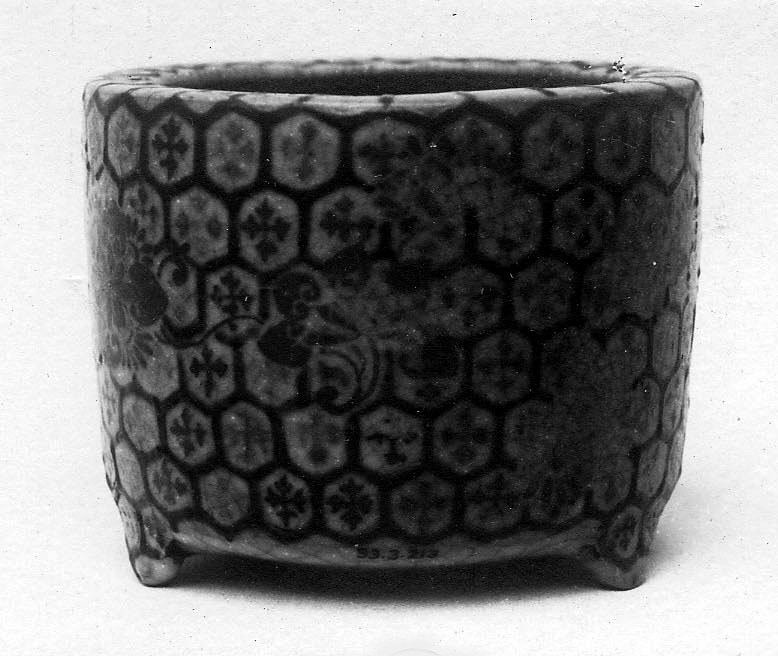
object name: incense burner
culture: japanese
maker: kinkozan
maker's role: artist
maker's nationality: japanese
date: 1750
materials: clay, enamel, glaze, gold